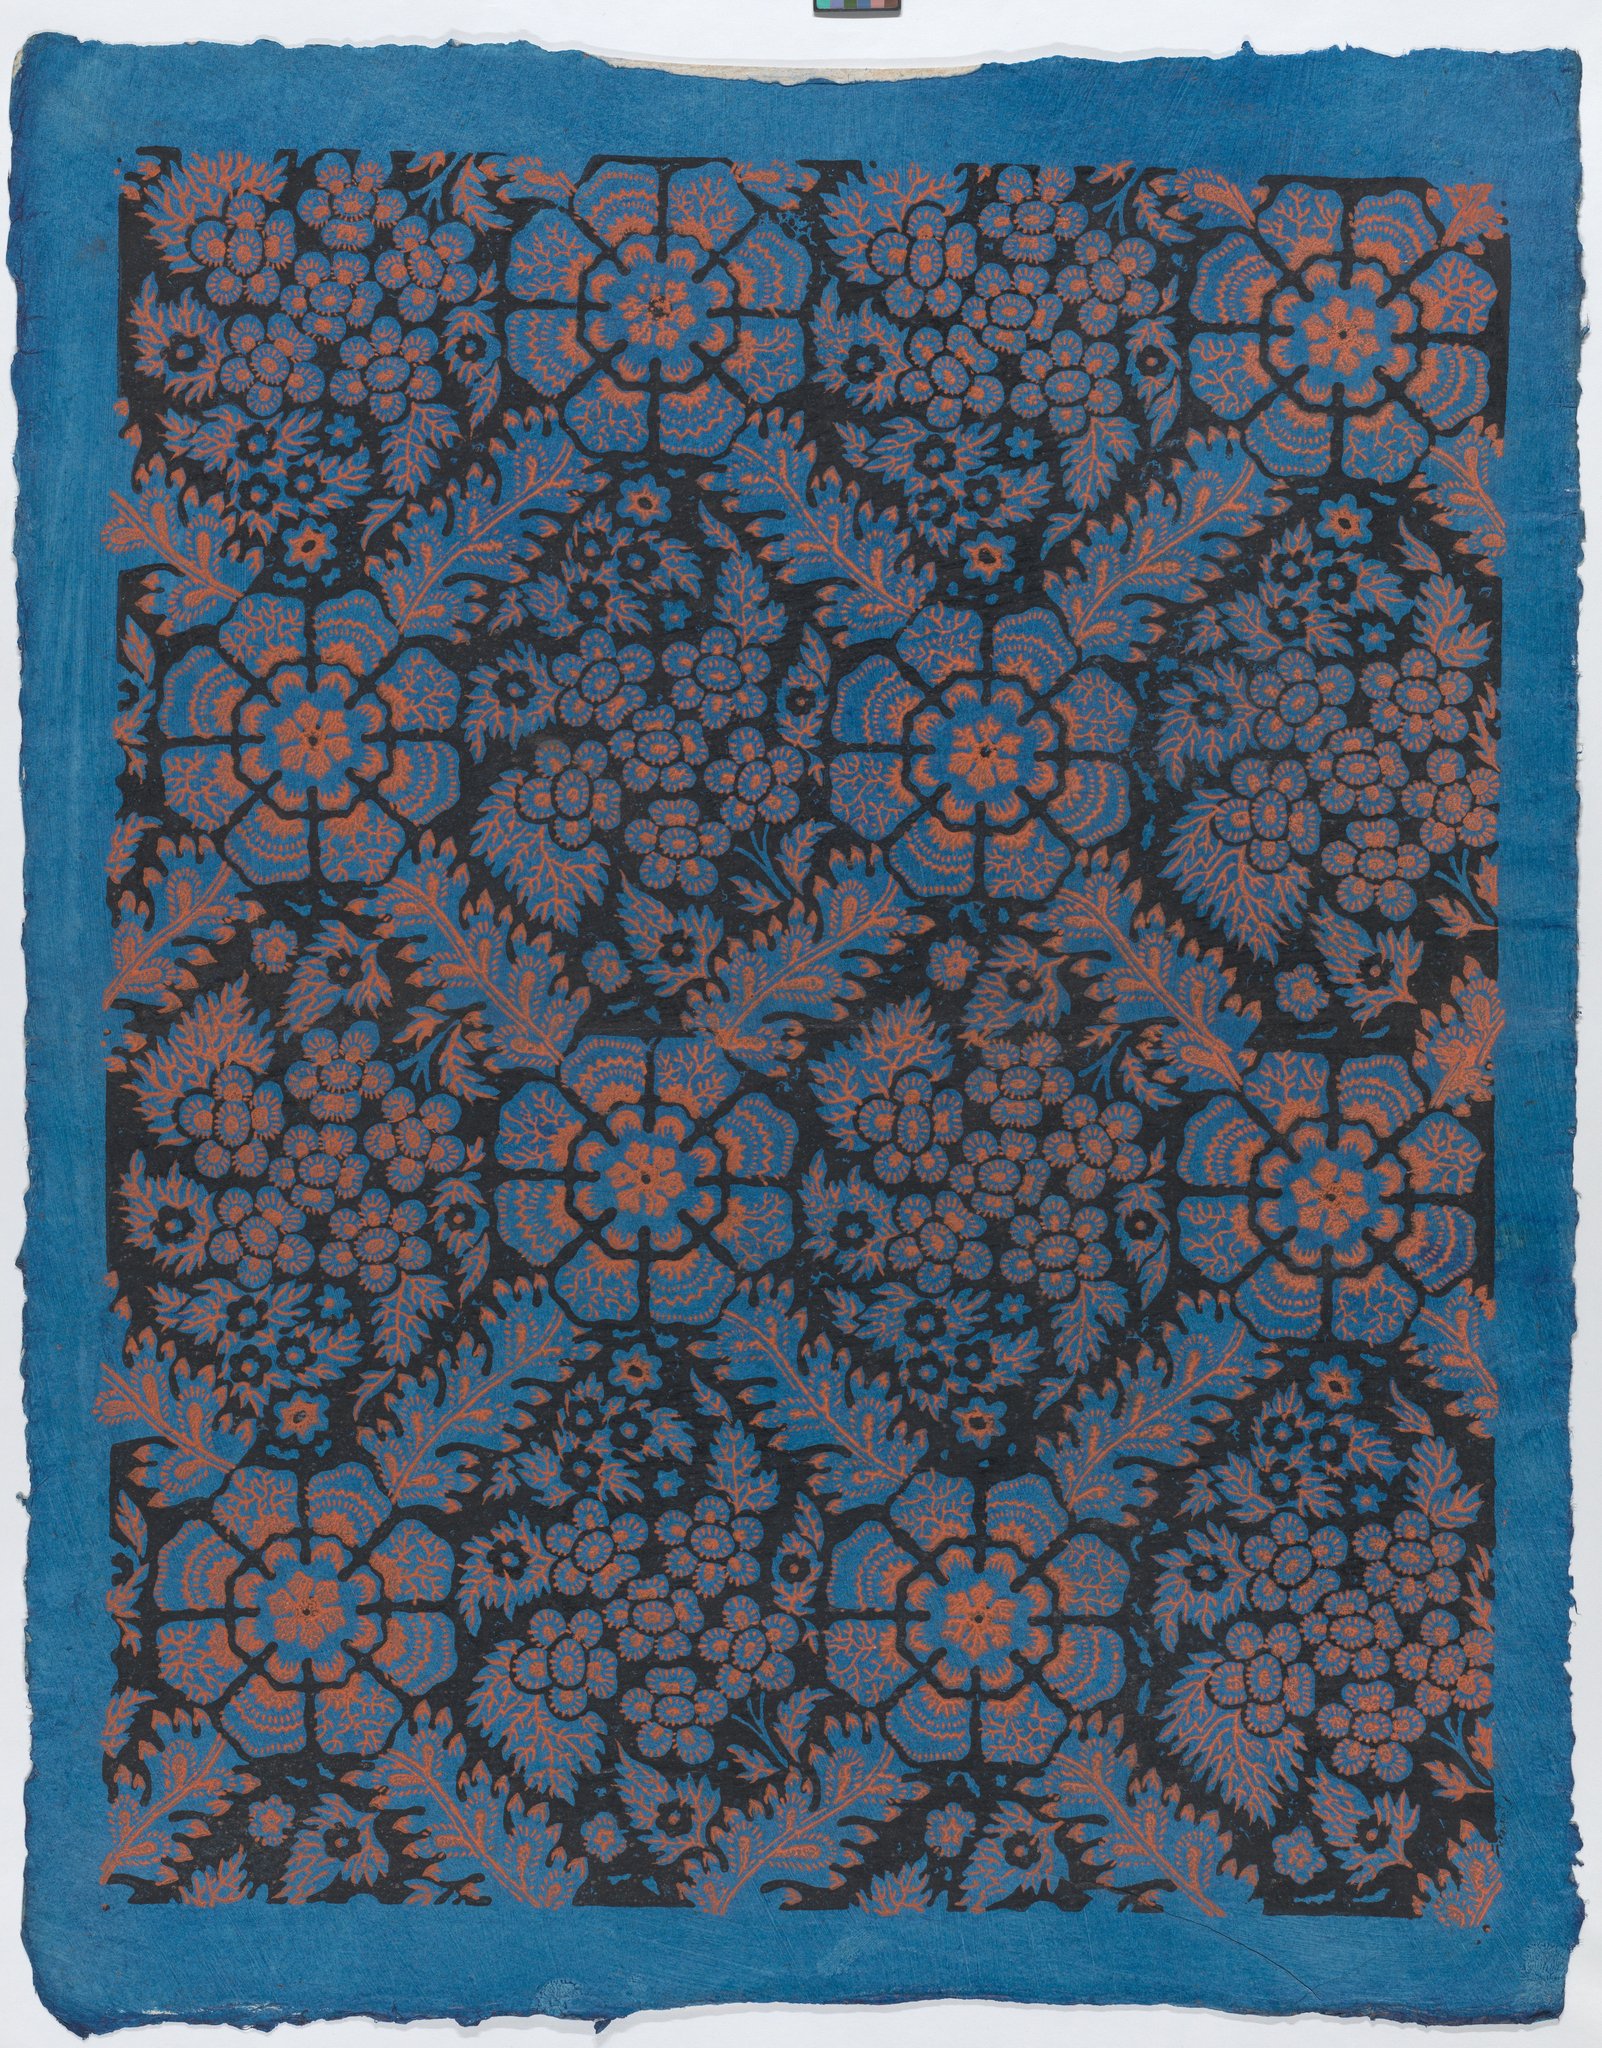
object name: print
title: Sheet with overall floral pattern on blue background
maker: Anonymous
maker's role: artist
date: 1767-1866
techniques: relief print